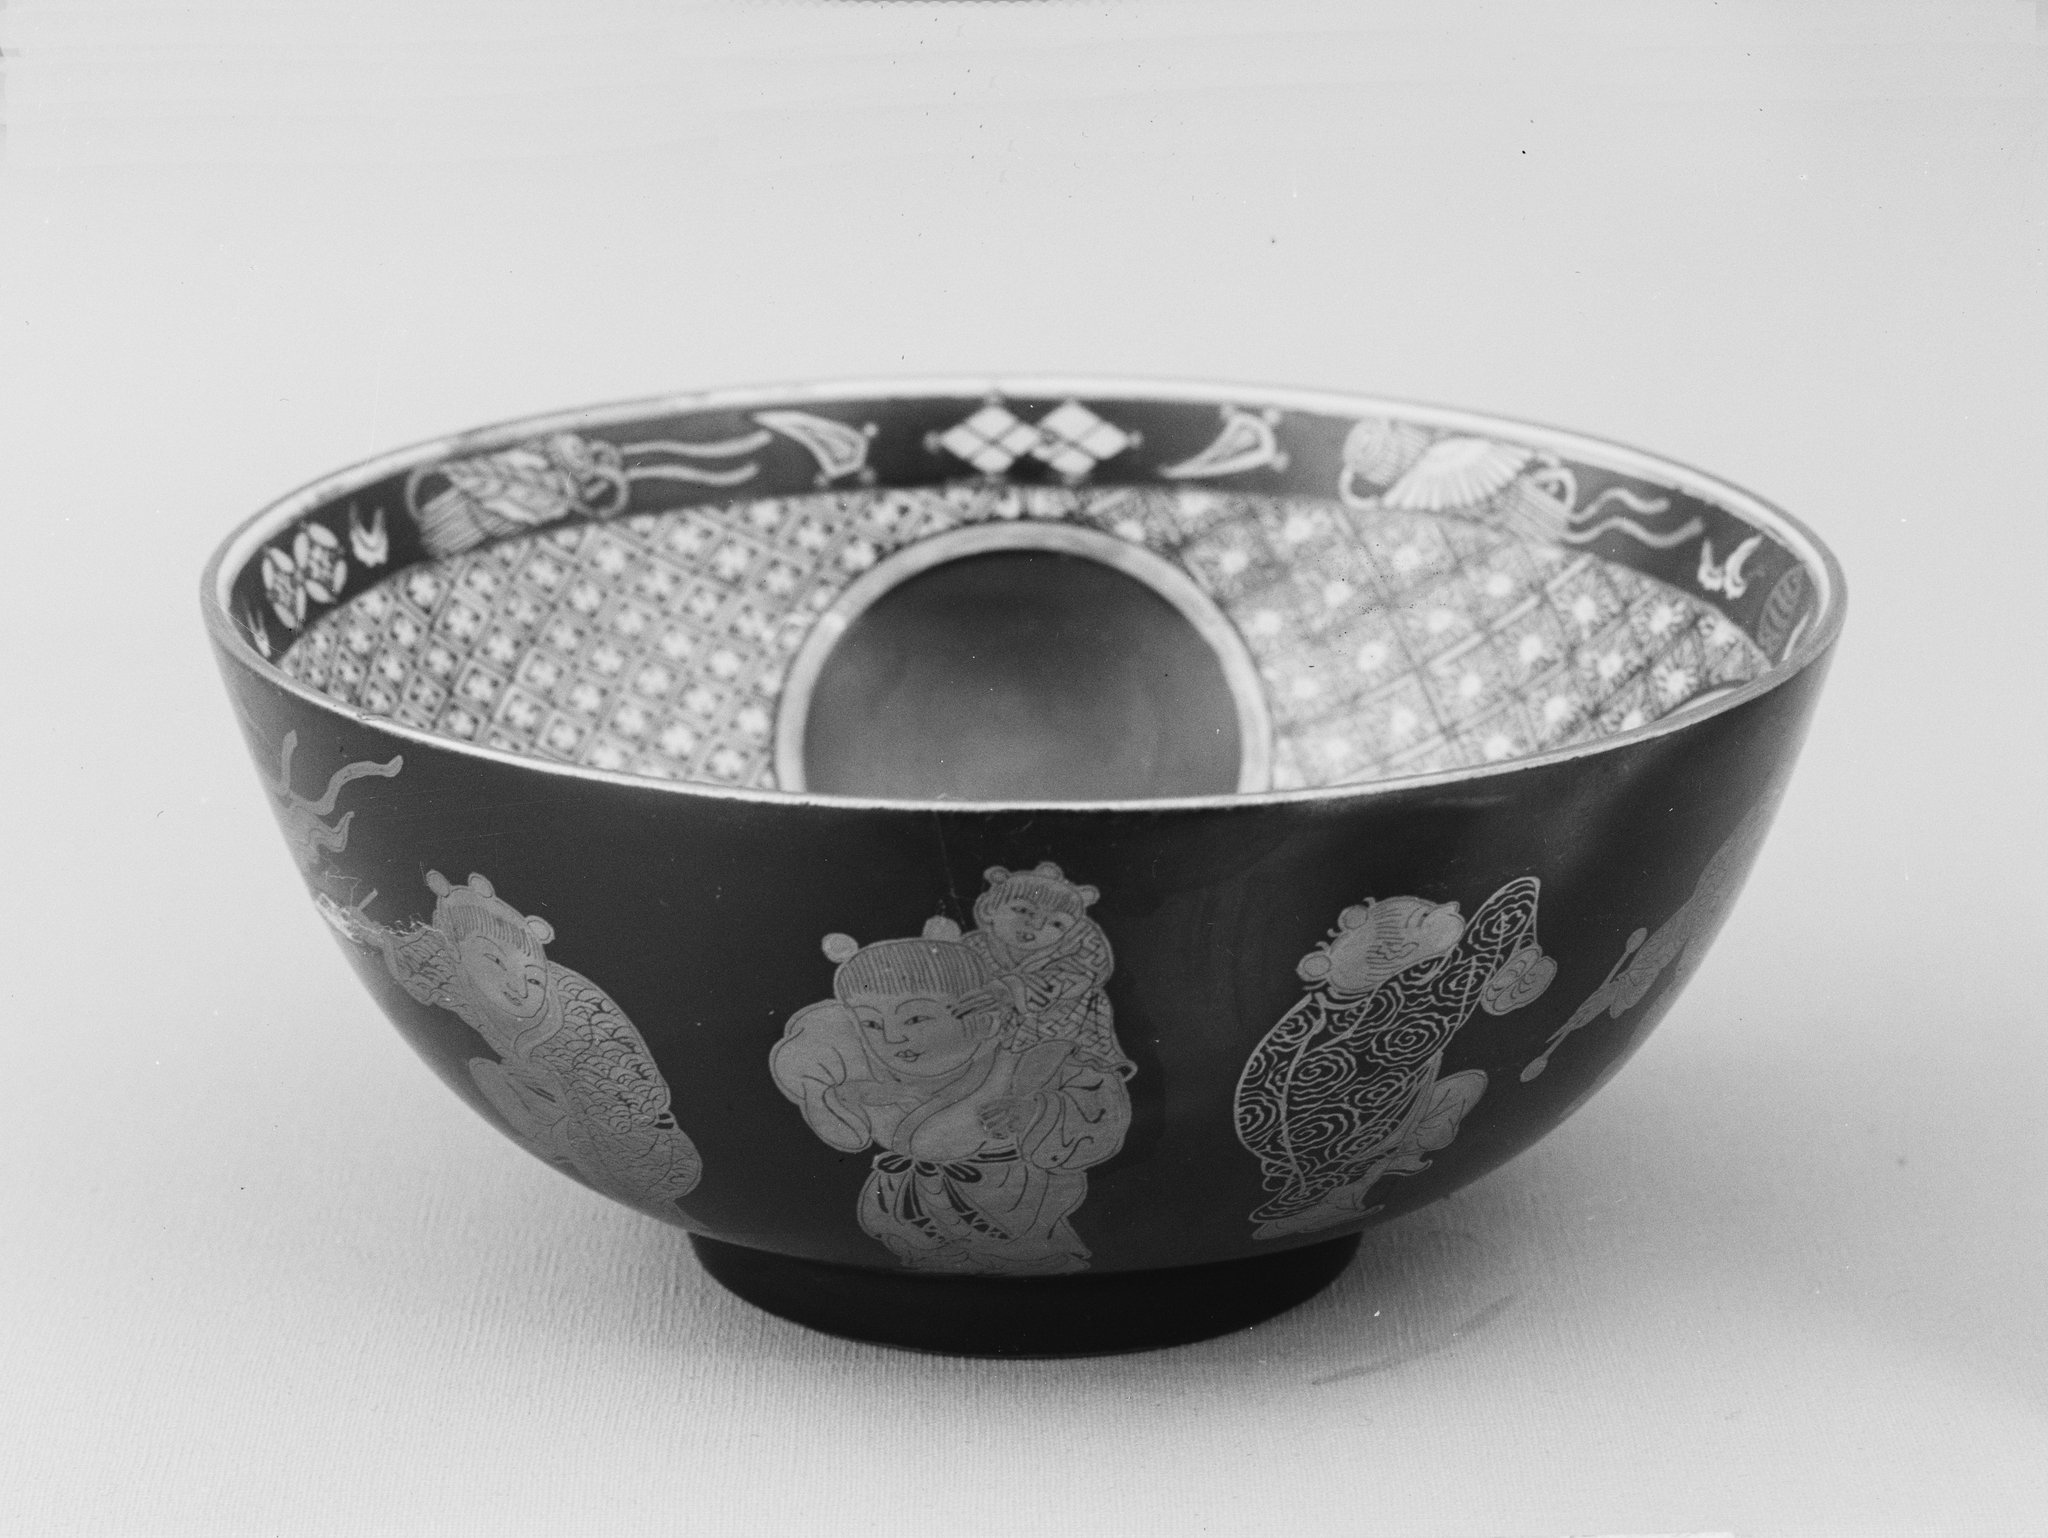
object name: bowl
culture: japanese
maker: seifu yohei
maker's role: artist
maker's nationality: japanese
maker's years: 1803-1861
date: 1801-1900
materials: enamel, glaze, porcelain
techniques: polychrome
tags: human figures